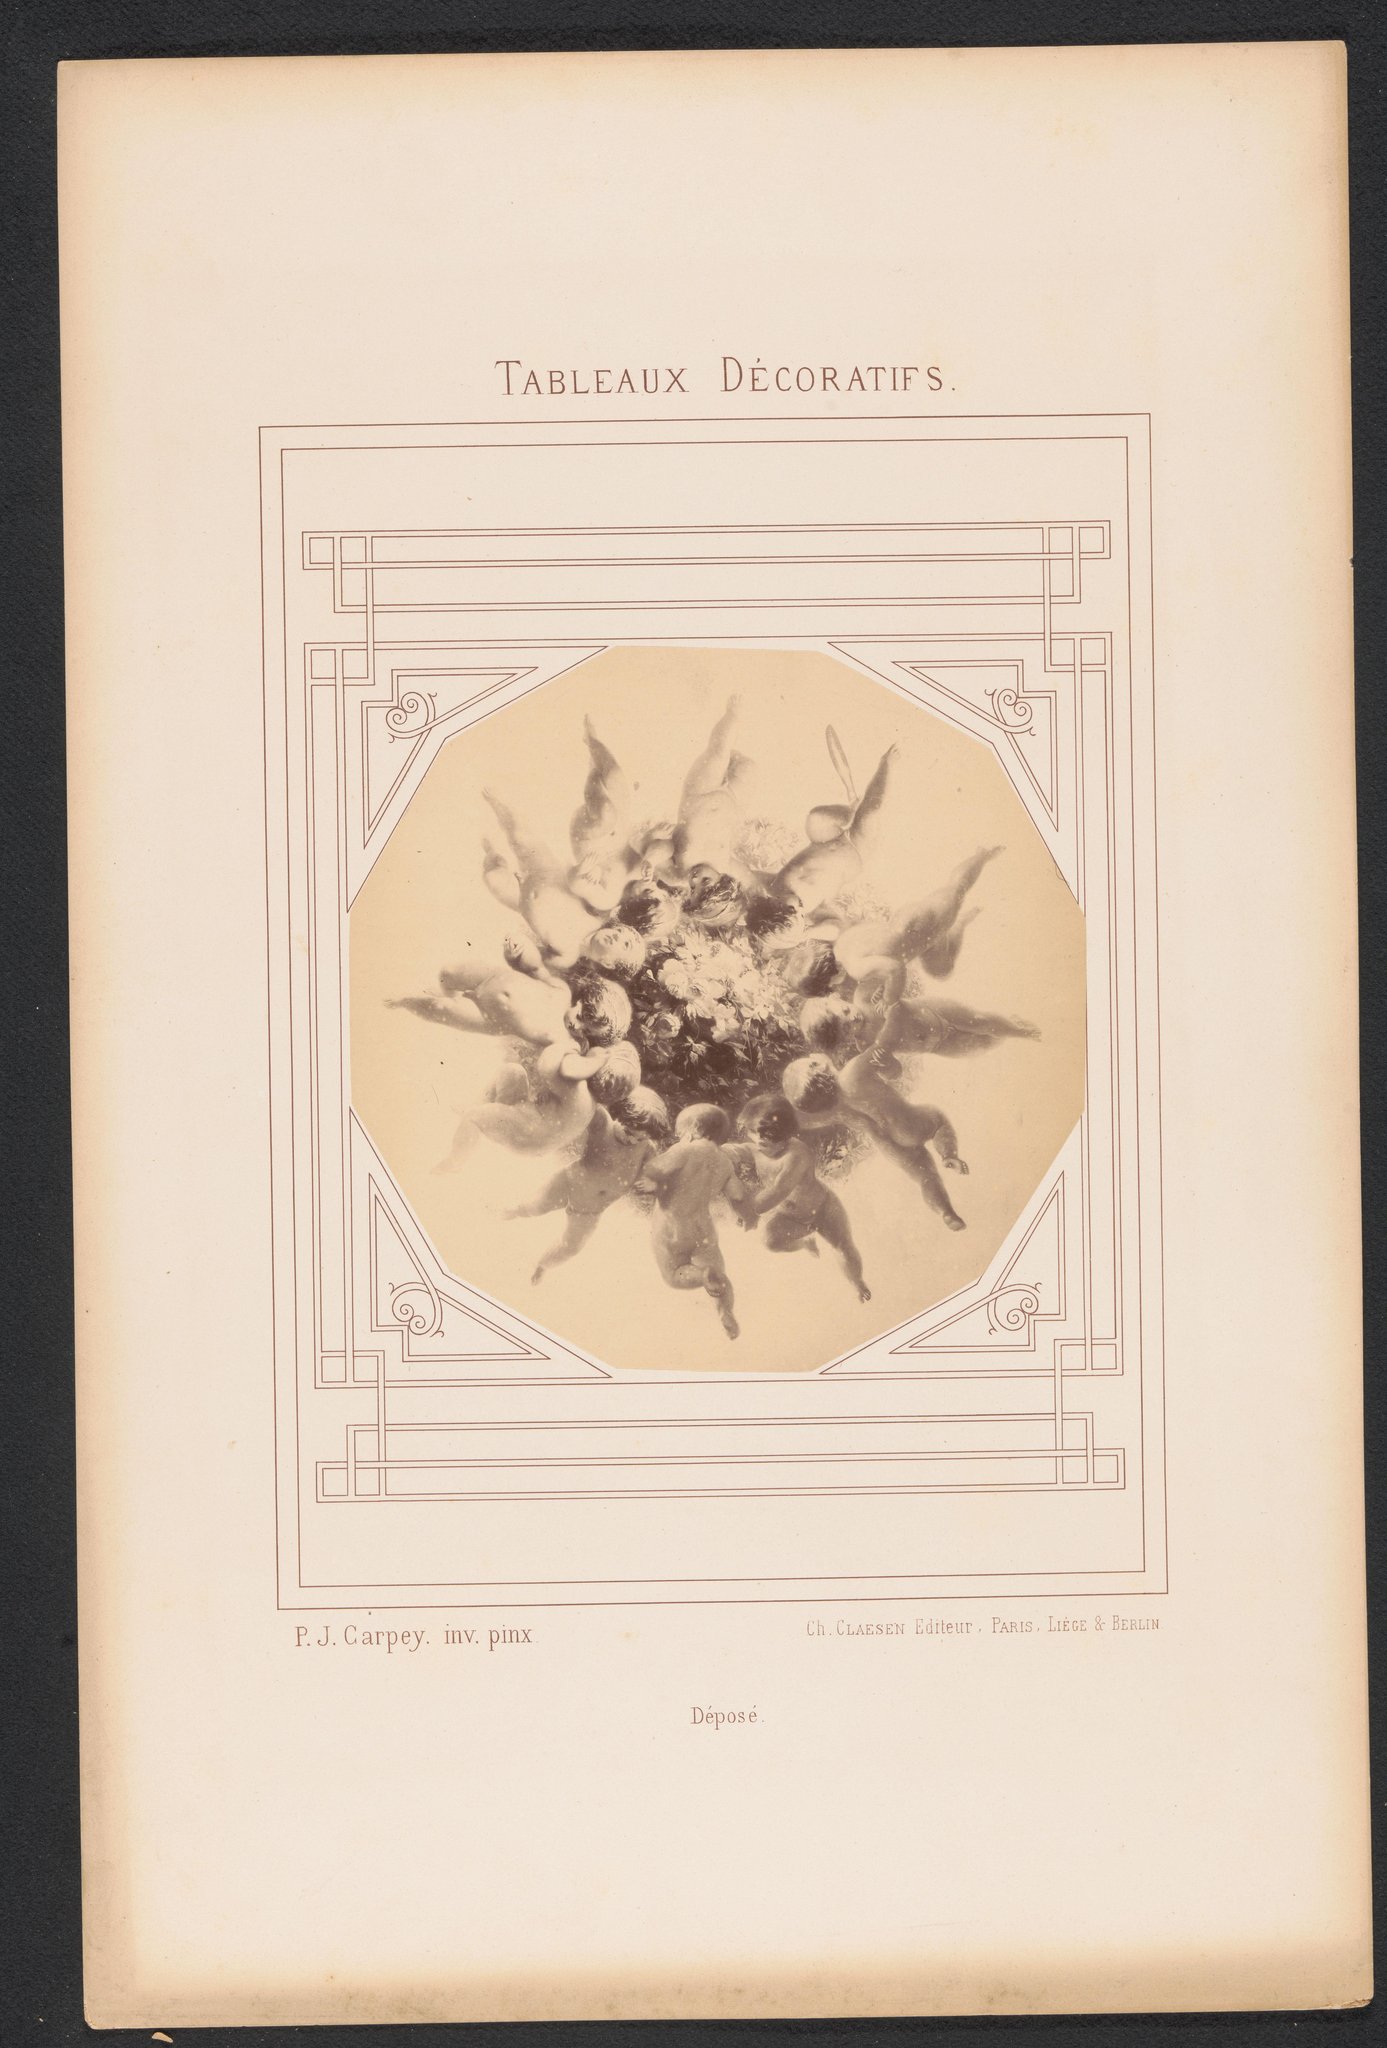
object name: reproduction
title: Tableaux Décoratifs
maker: paul-joseph carpay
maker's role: painter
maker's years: 1822-1892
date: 1874-1881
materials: photographic support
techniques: albumen print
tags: cupids: 'amores', 'amoretti', 'putti'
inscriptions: inscription: ‘Ch. Claesen Editeur , Paris , Liége & Berlin’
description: Deze foto maakt deel uit van een omslag met 24 foto's op 22 bladen.